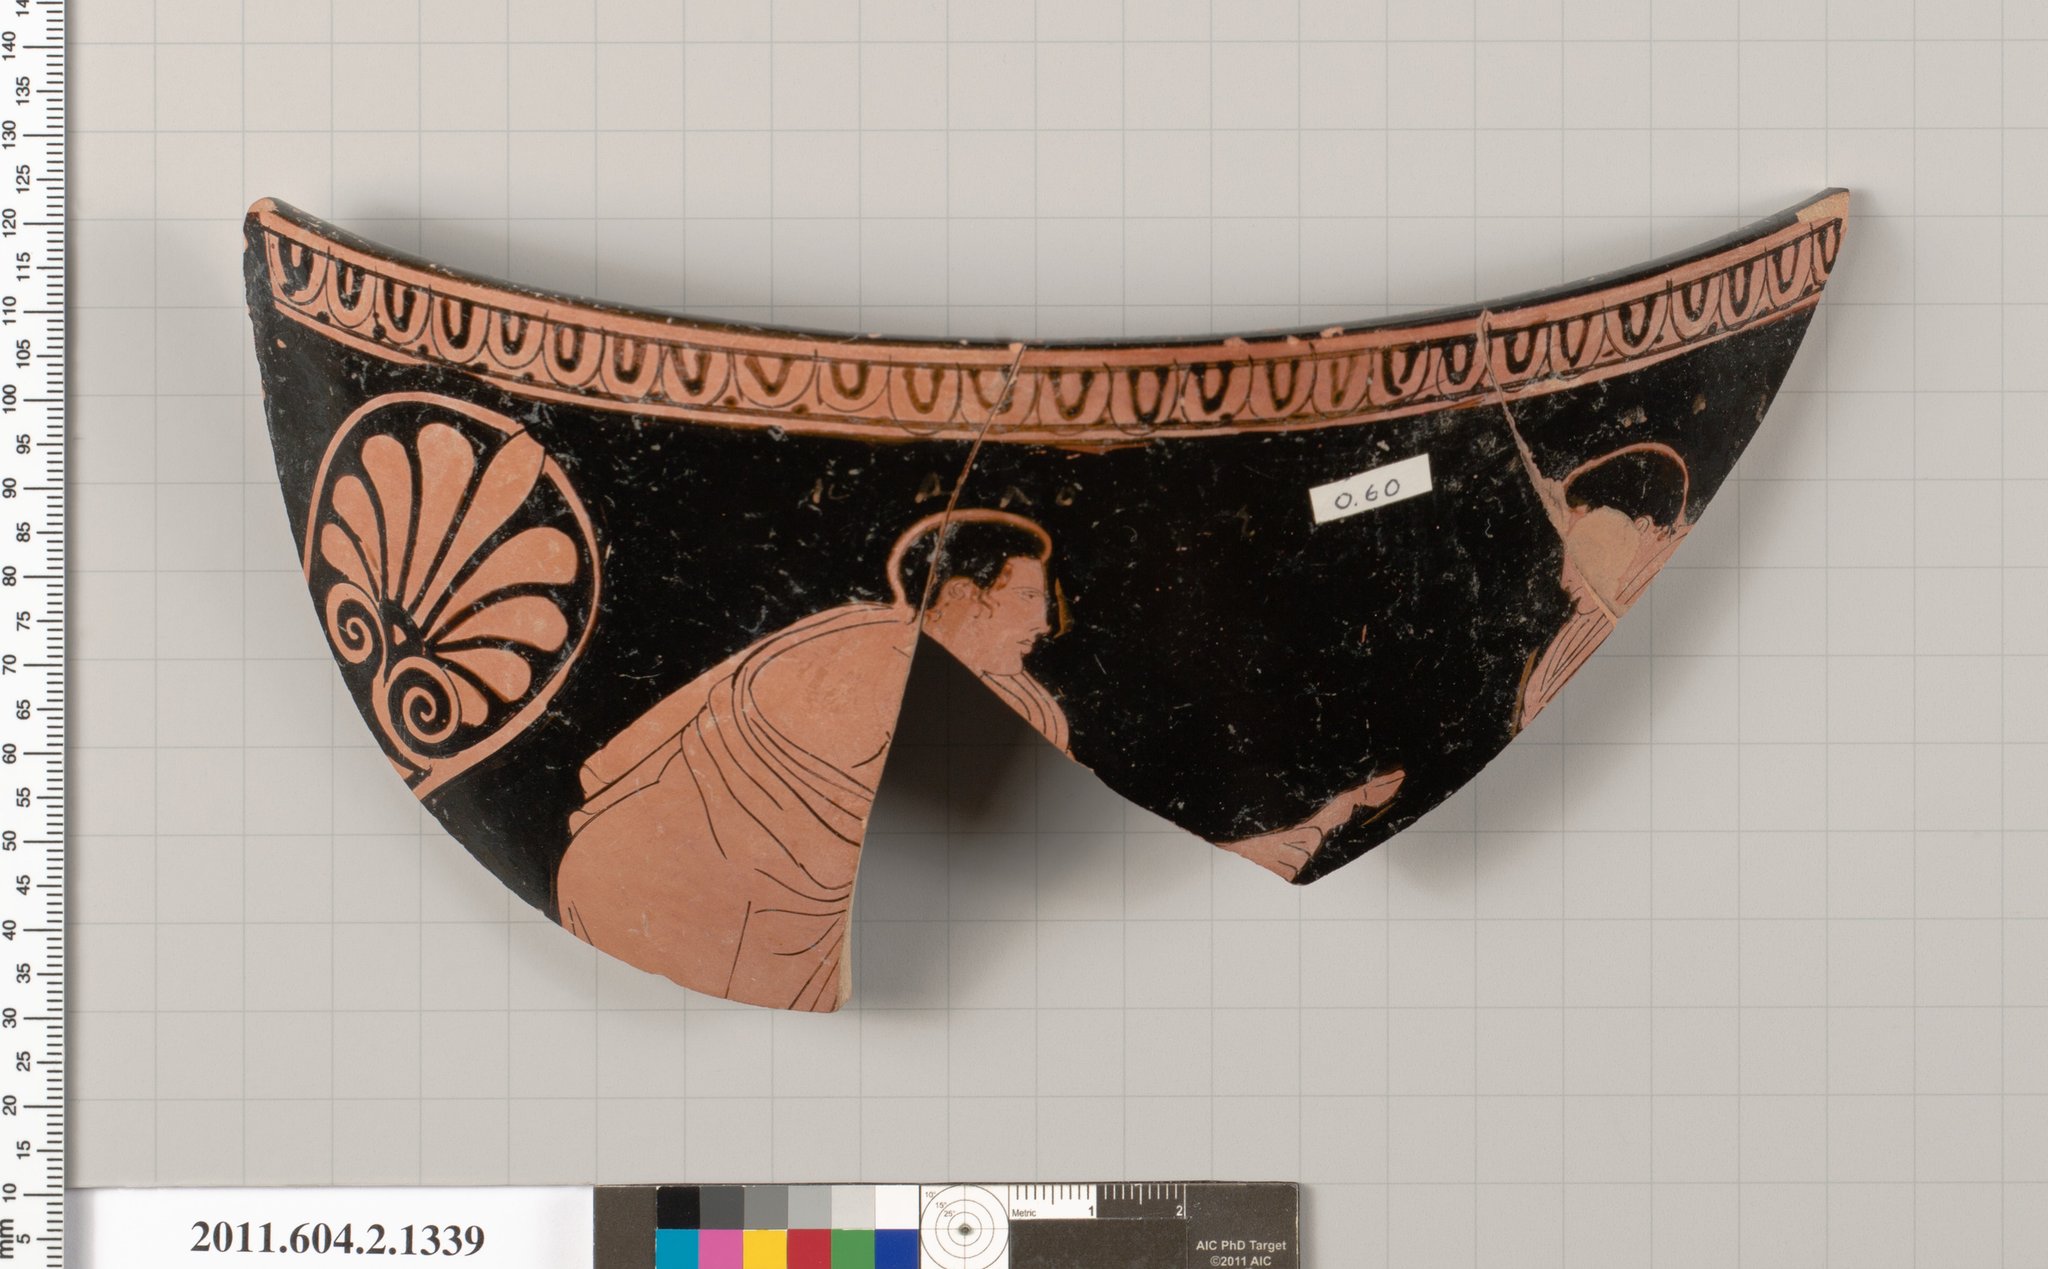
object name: skyphos fragment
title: Terracotta fragment of a skyphos (deep drinking cup)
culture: greek, attic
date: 450-440 BCE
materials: terracotta